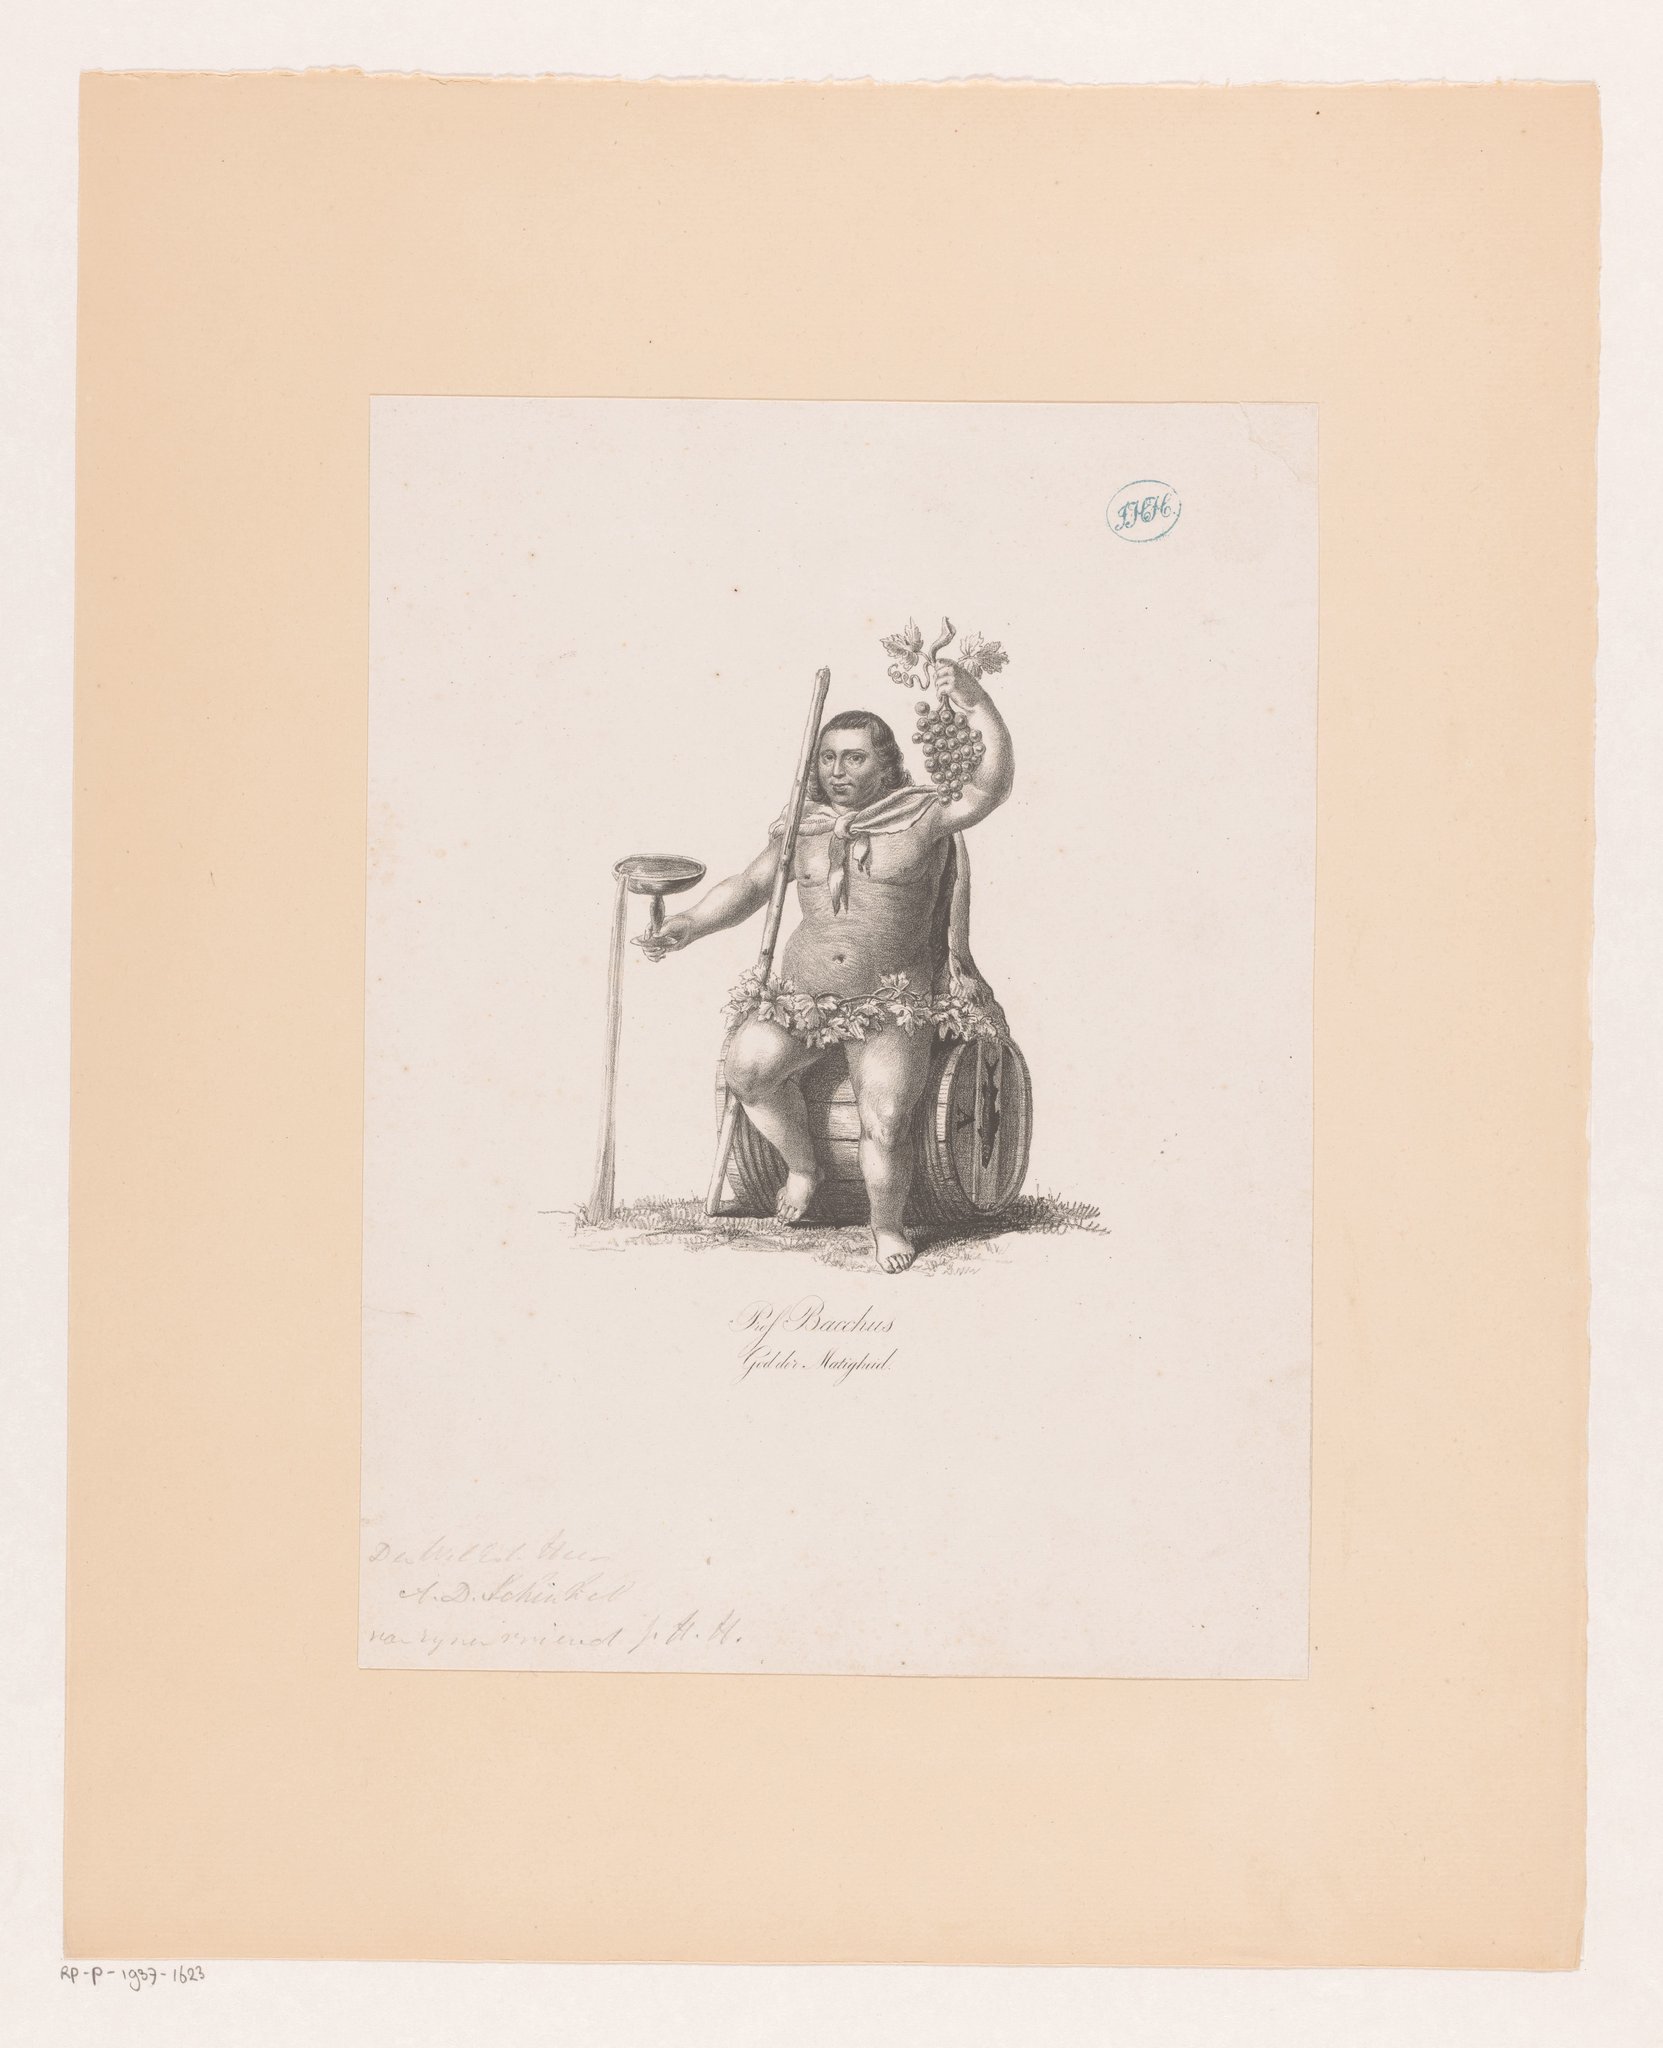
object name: caricature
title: Portret van Jodocus Herwiga Elizareon als Bacchus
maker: johan hendrik hoffmeister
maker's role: print maker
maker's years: 1823-1904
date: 1843-1904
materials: paper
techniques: lithograph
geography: netherlands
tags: (story of) bacchus (dionysus), liber, historical persons (+ full length portrait)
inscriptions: collector's mark: Lugt 2760, stamp: ‘J. H. H.’, dedication: ‘Den Wel. Ed. Heer / A. D. Schinkel / van zijnen vriend, J. H. H.’, collector's mark: Lugt 2228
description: Bij de prent is een losse notitie opgezet. Daarin wordt beschreven dat deze prent van Jodocus Herwiga Elizareon, professor theologie in Utrecht, werd gemaakt nadat hij zijn studenten had aangespoord lid te worden van het 'matigheids genootschap'. De prent werd onder vrienden van de geportretteerde verspreid, daarvan getuigt ook de opdracht op de voorkant van de prent.